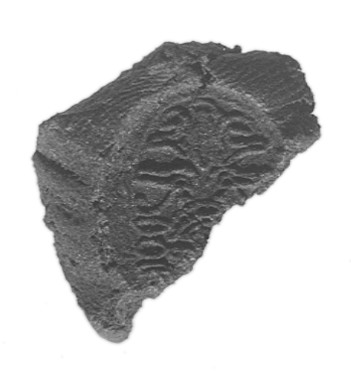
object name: sealing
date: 2030-1640 BCE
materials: clay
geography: egypt